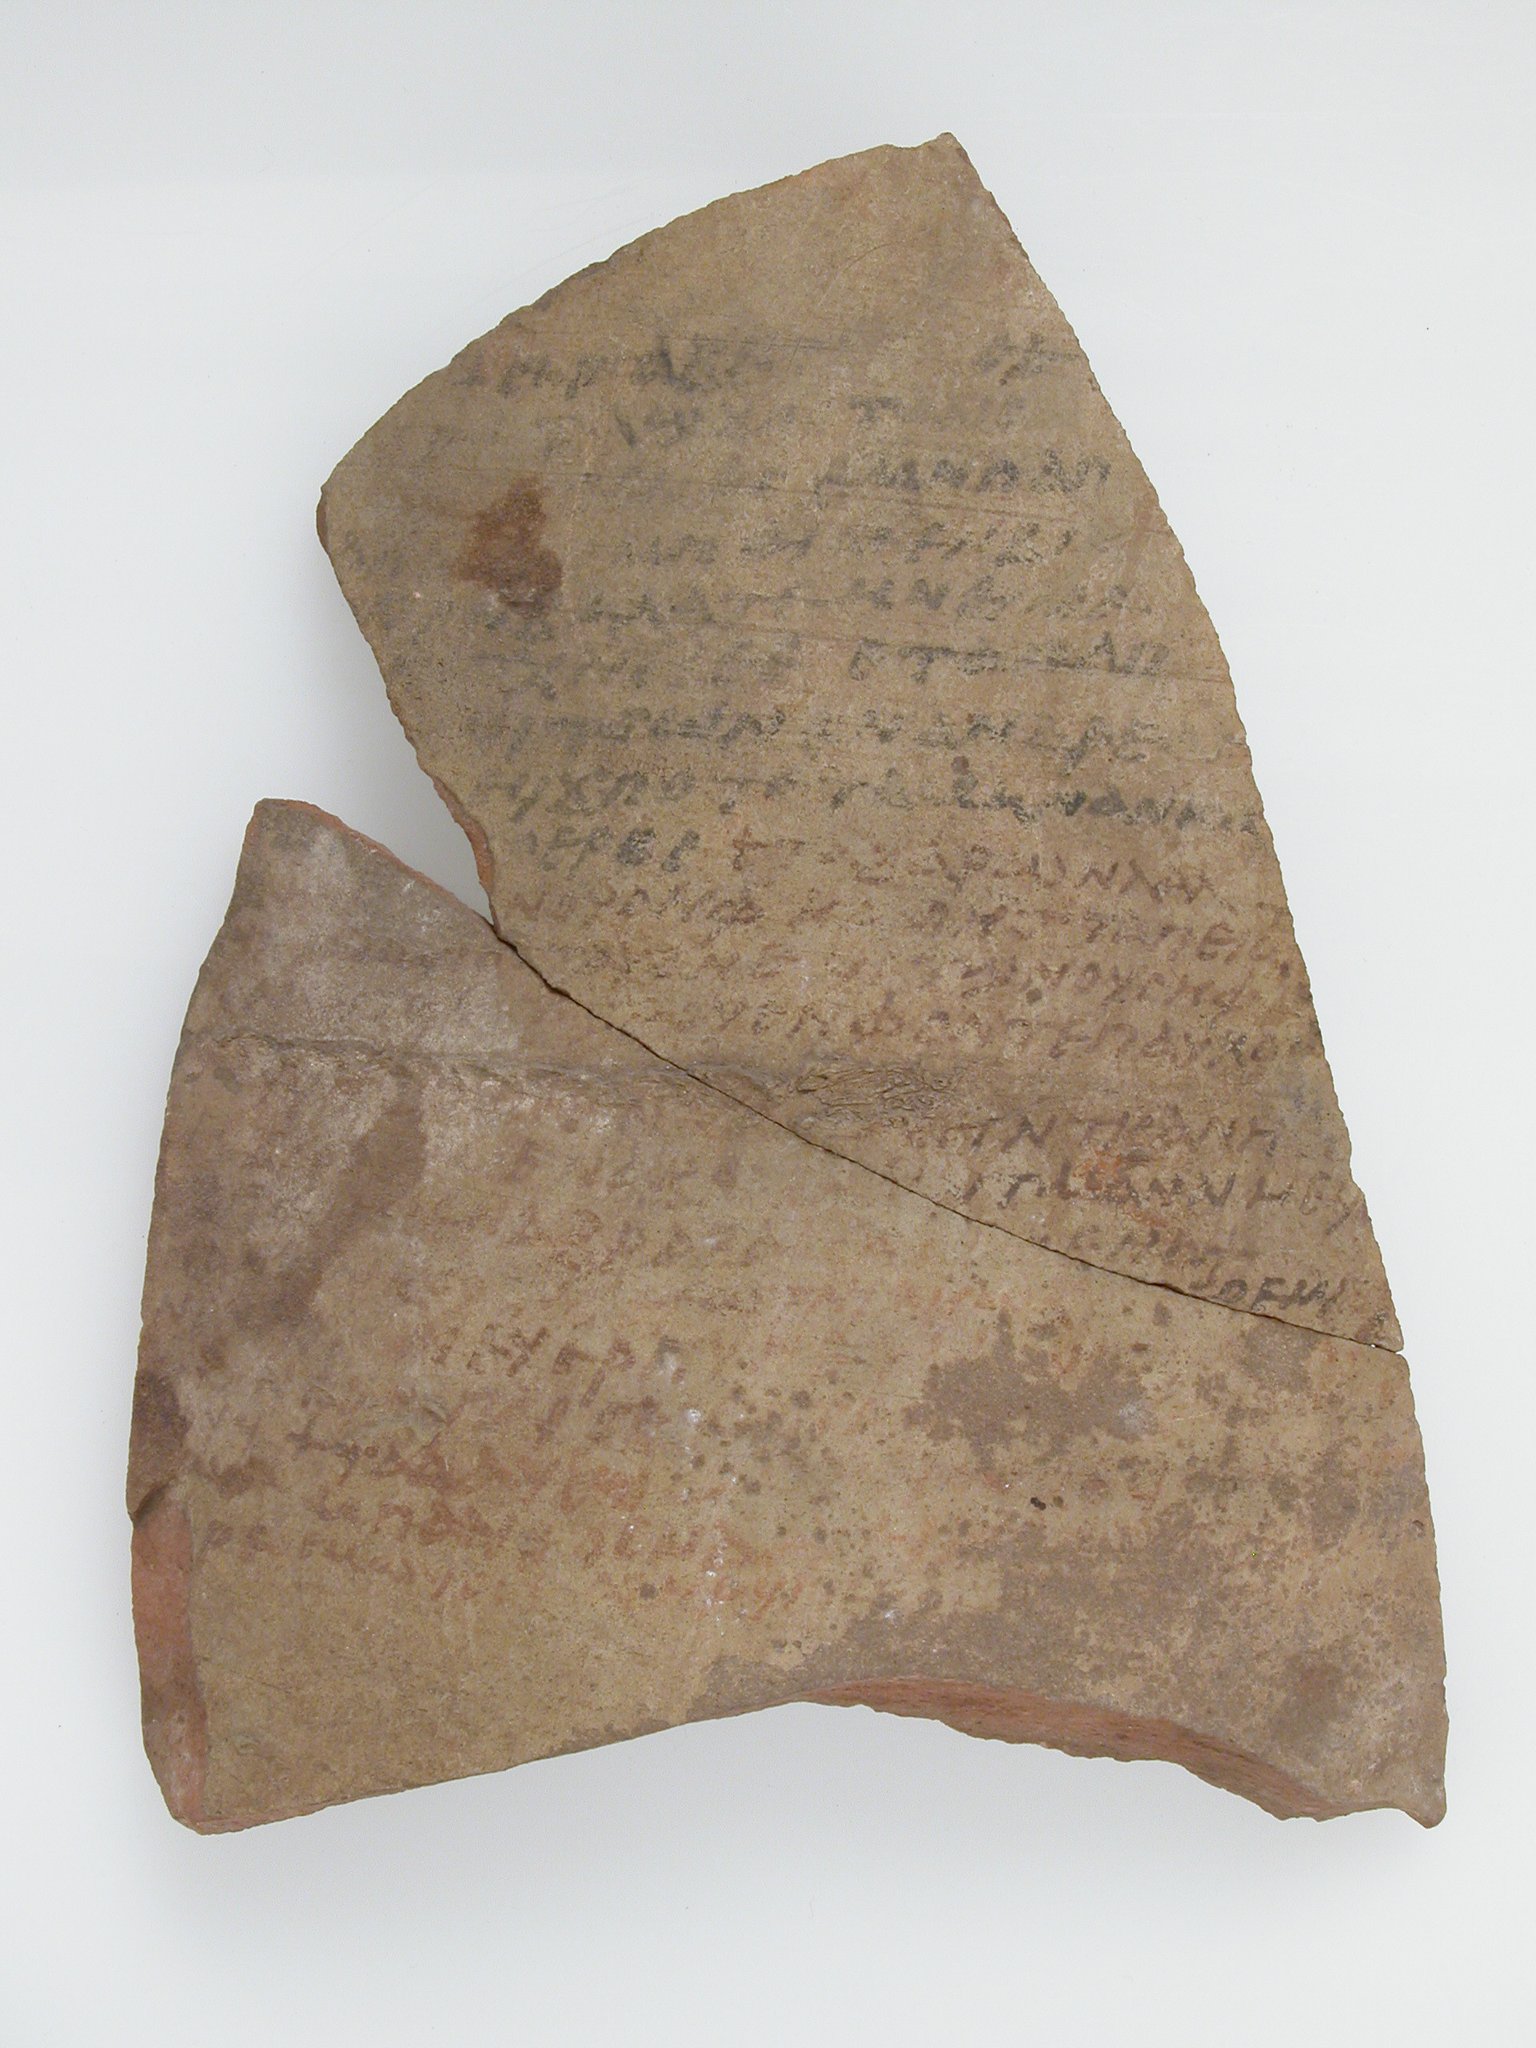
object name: ostrakon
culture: coptic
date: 601-700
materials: ink, pottery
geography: egypt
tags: documents